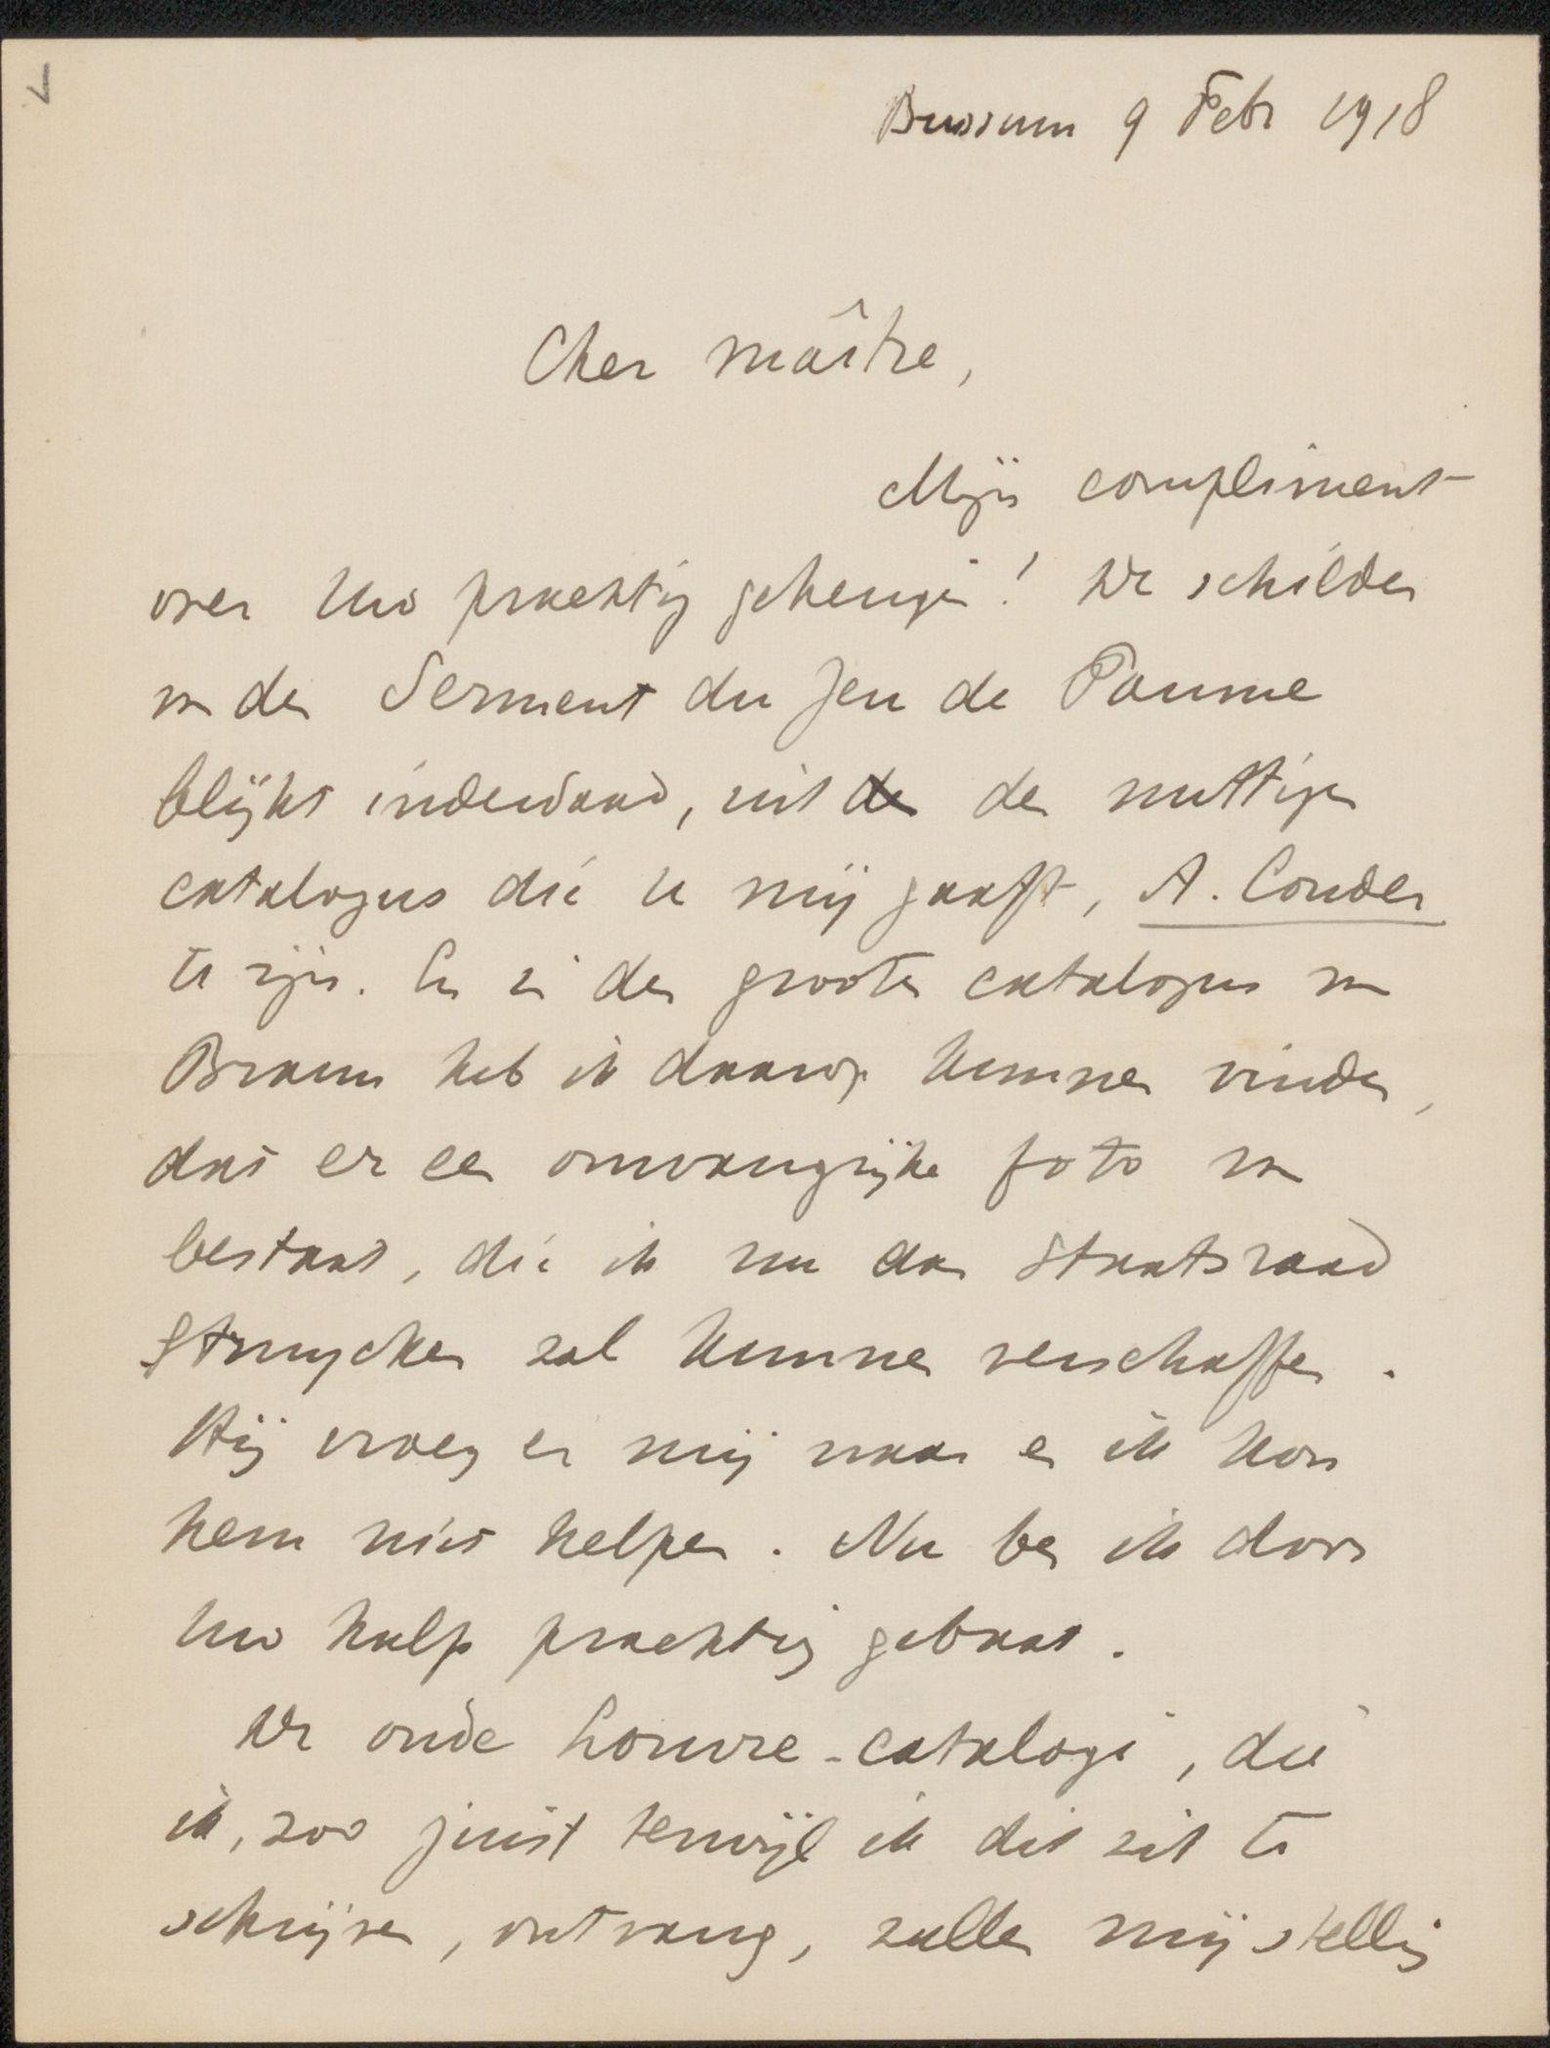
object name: letter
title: Brief aan Jan Veth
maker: august allebé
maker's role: draughtsman, print maker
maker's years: 1838-1927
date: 1918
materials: ink, paper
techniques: pen, writing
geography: bussum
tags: dordrecht, amsterdam, jan veth, edmond de schampheleer, alfred de knyff, paris, painter, draughtsman, designer, auguste couder, painting (including book-illumination, miniature-painting), printed matter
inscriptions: watermark, collector's mark: ‘RPK’